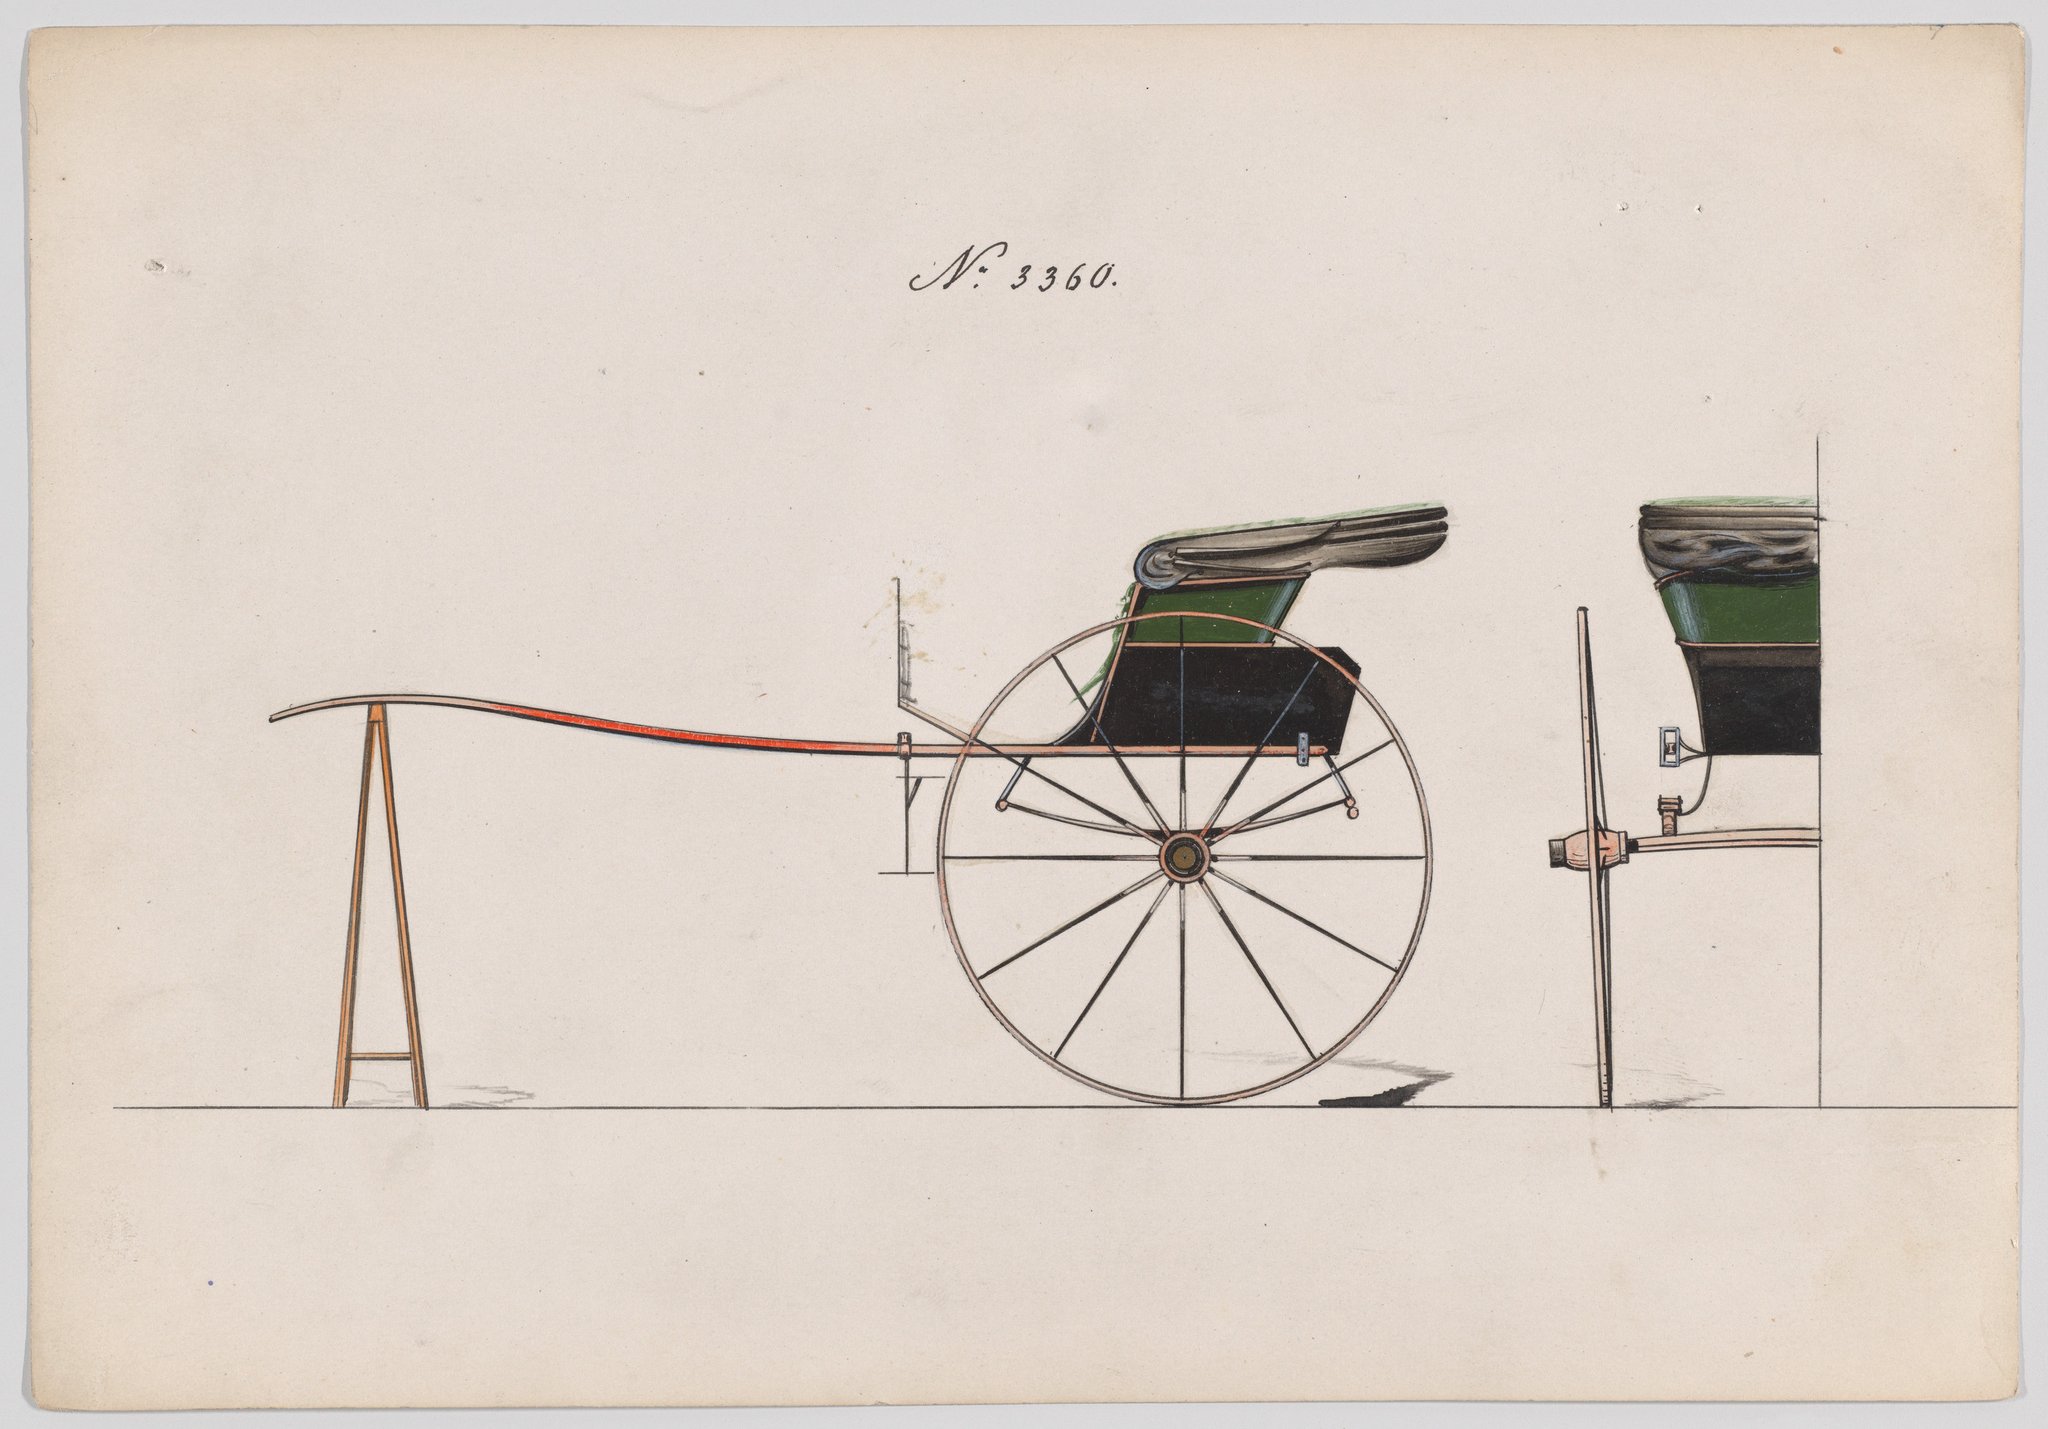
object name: drawing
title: Gig #3360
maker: brewster & co.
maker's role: manufacturer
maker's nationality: american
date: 1877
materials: gouache, gum arabic, watercolor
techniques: pen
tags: carriages